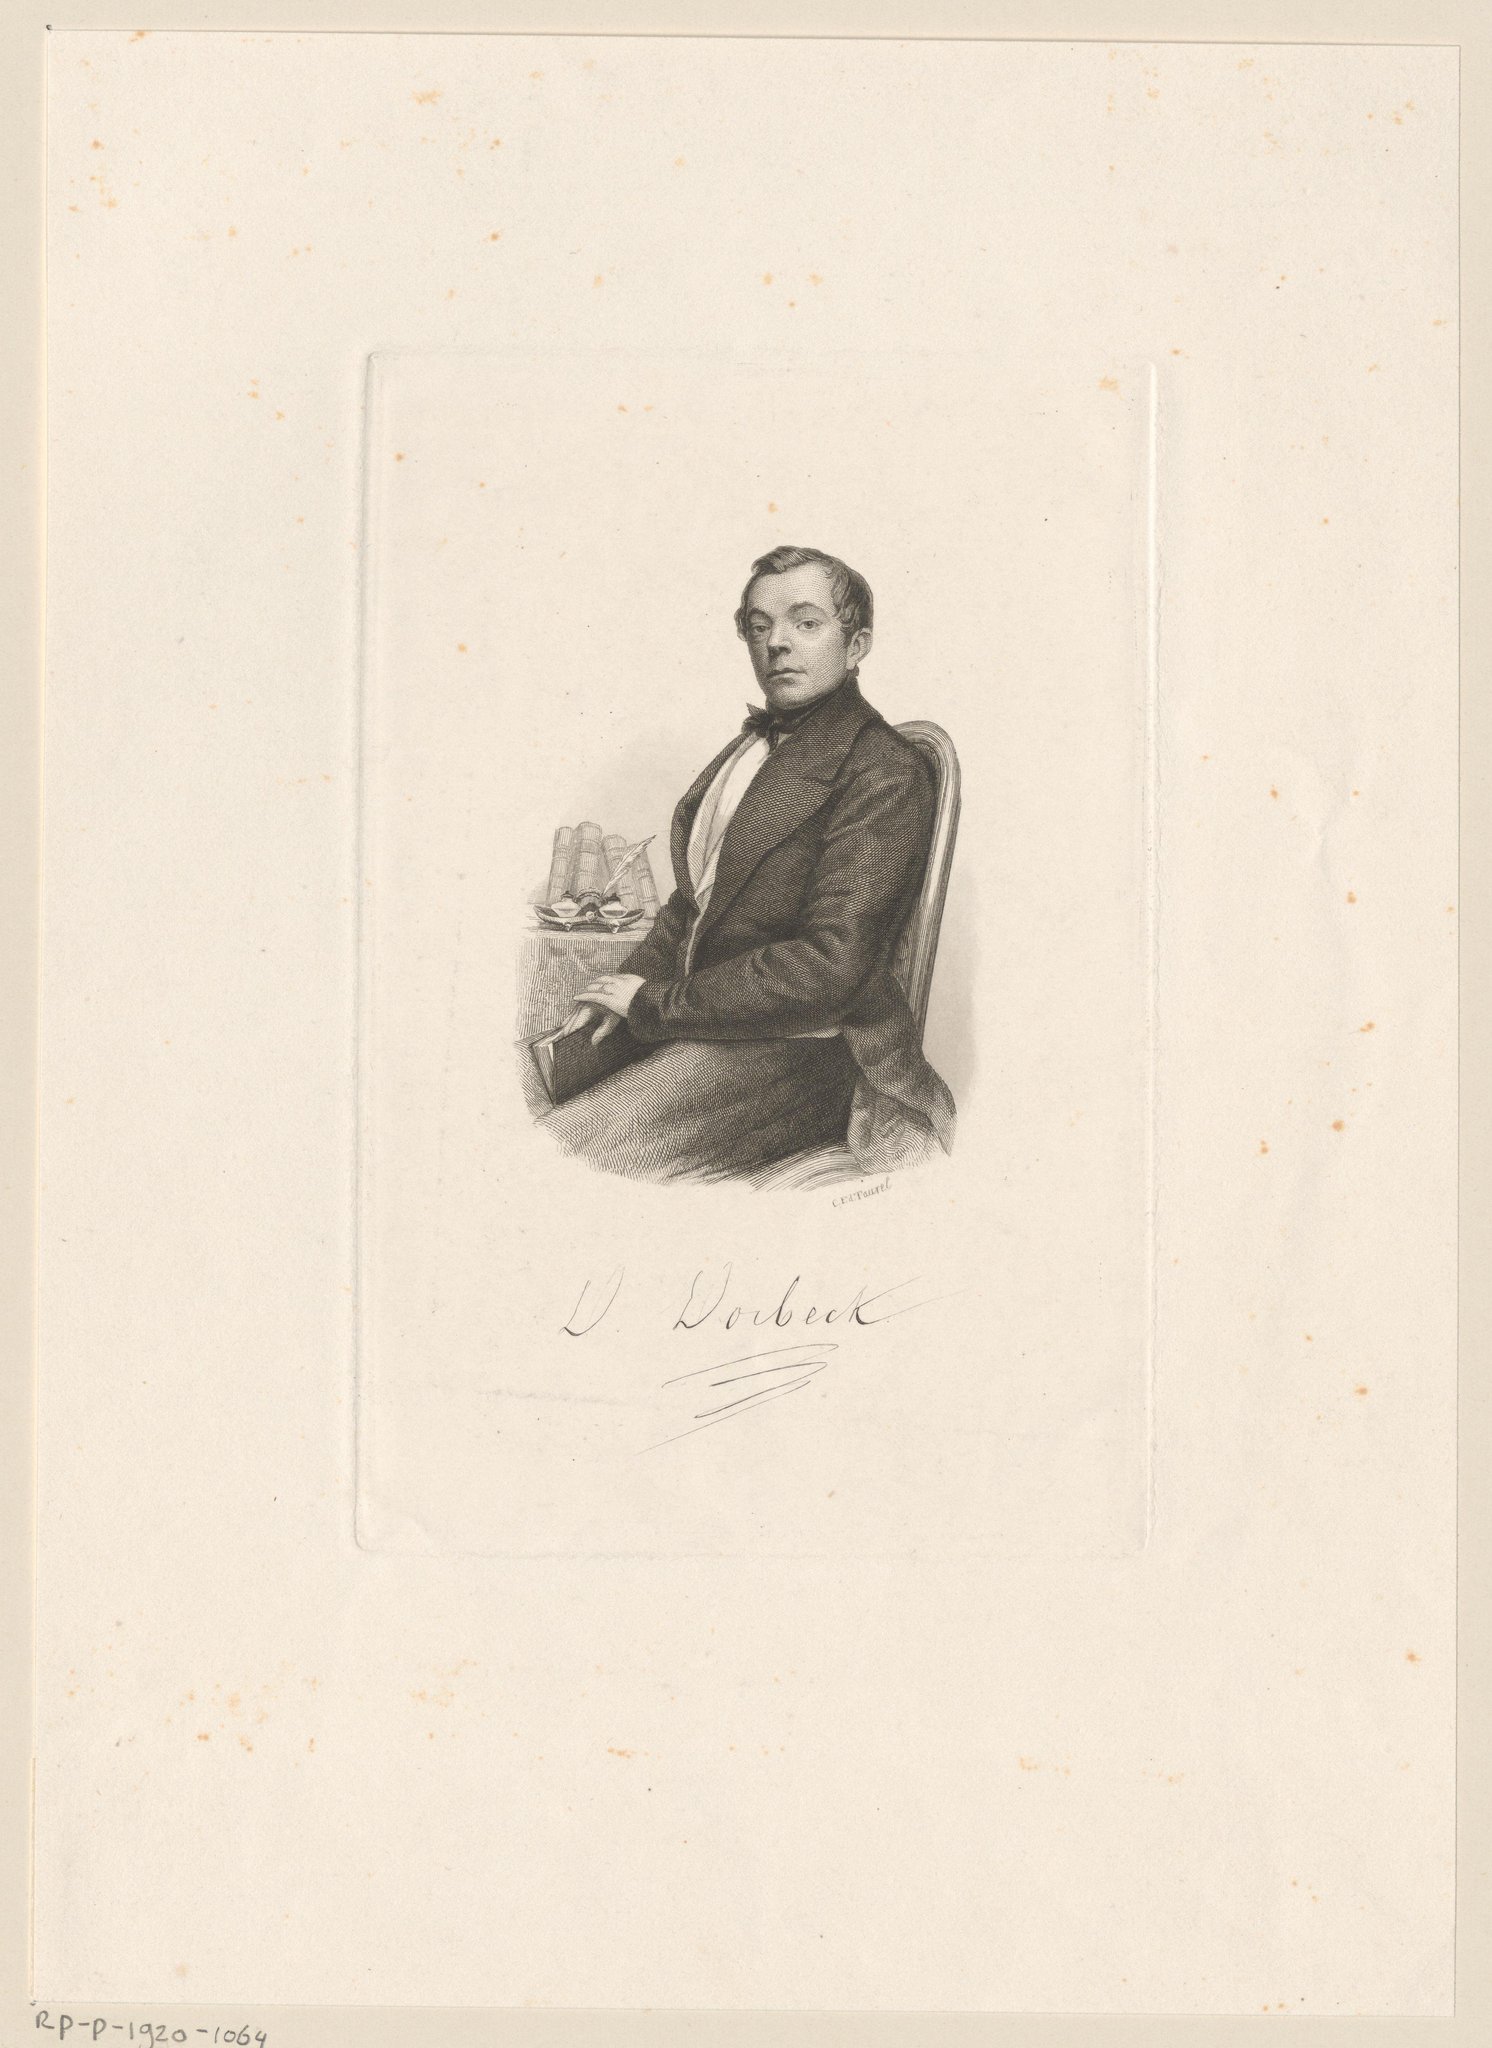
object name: print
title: Portret van Didericus Dorbeck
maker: edouard taurel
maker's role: draughtsman, print maker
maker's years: 1824-1892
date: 1855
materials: paper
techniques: engraving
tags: schagen, writing tools, historical persons, book, writer, poet, author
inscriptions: collector's mark: Lugt 2228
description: Prent mogelijk gebruikt in: Vergeet mij niet. Muzen-almanak 37 (1855).